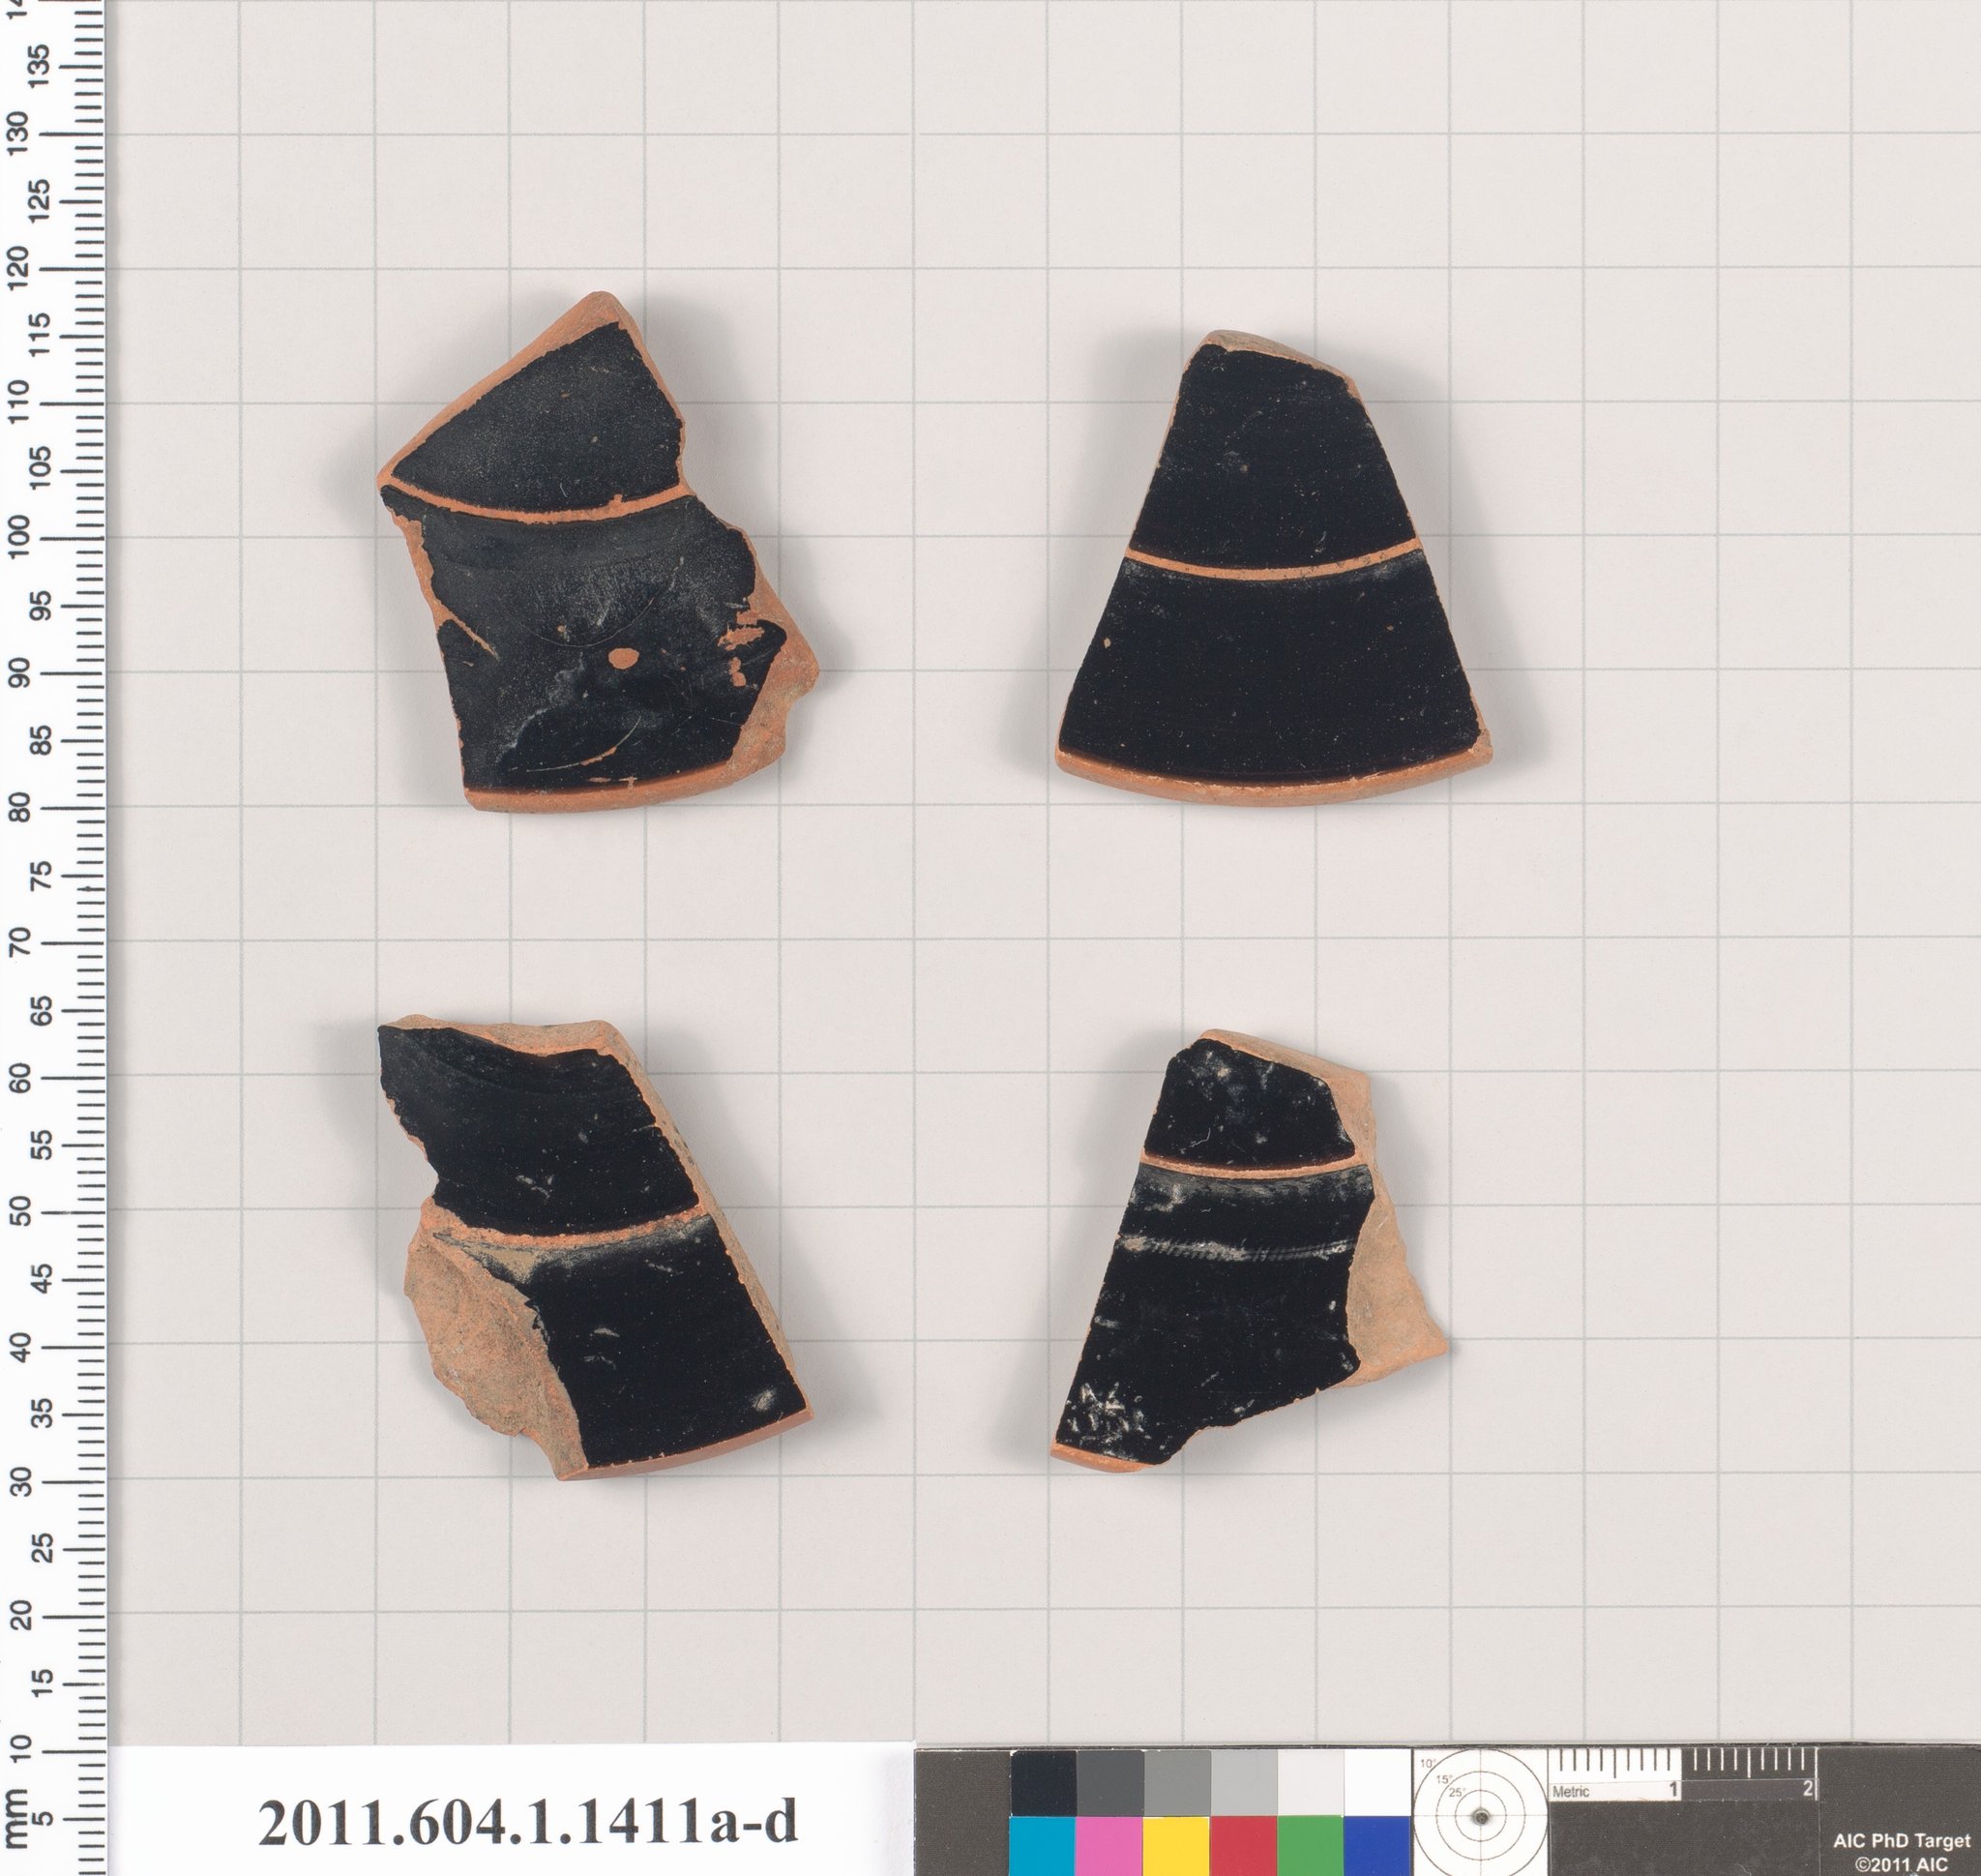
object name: kylix fragment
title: Terracotta fragments of kylikes (drinking cups)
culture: greek, attic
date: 500-401 BCE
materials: terracotta